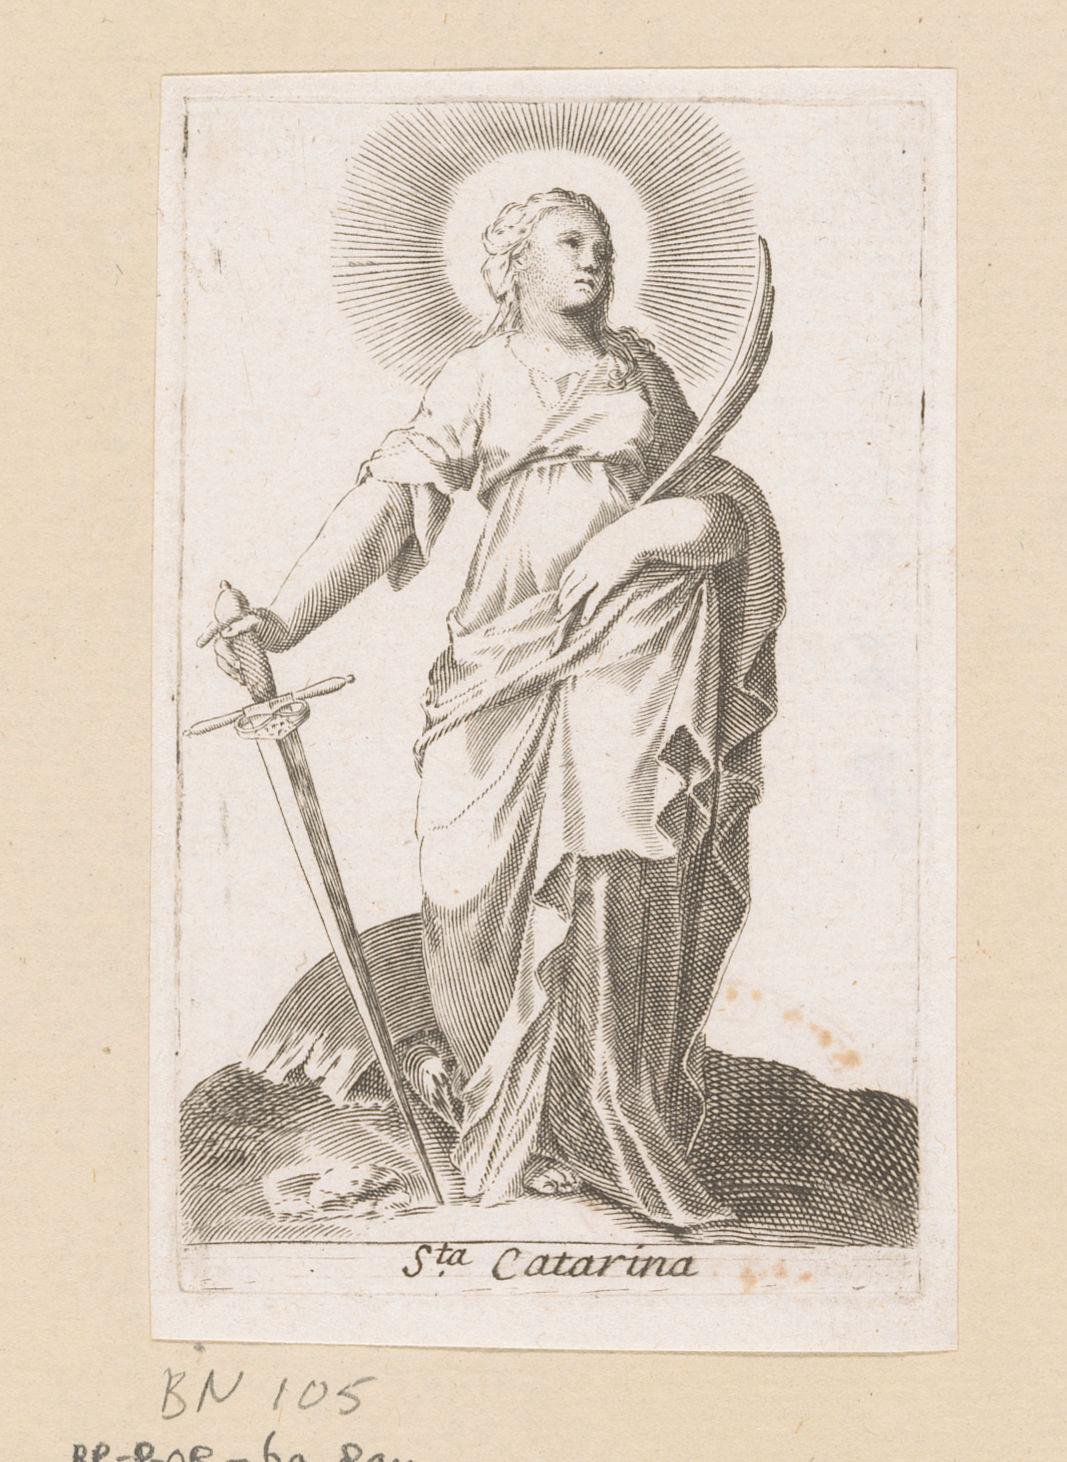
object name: print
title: H. Catharina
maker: claude mellan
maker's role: draughtsman, print maker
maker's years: 1598-1688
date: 1608-1688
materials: paper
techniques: engraving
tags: the virgin martyr catherine of alexandria; possible attributes: book, crown, emperor maxentius, palm-branch, ring, sword, wheel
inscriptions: collector's mark: Lugt 240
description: Maakt mogelijk deel uit van een serie met verschillende heiligen.